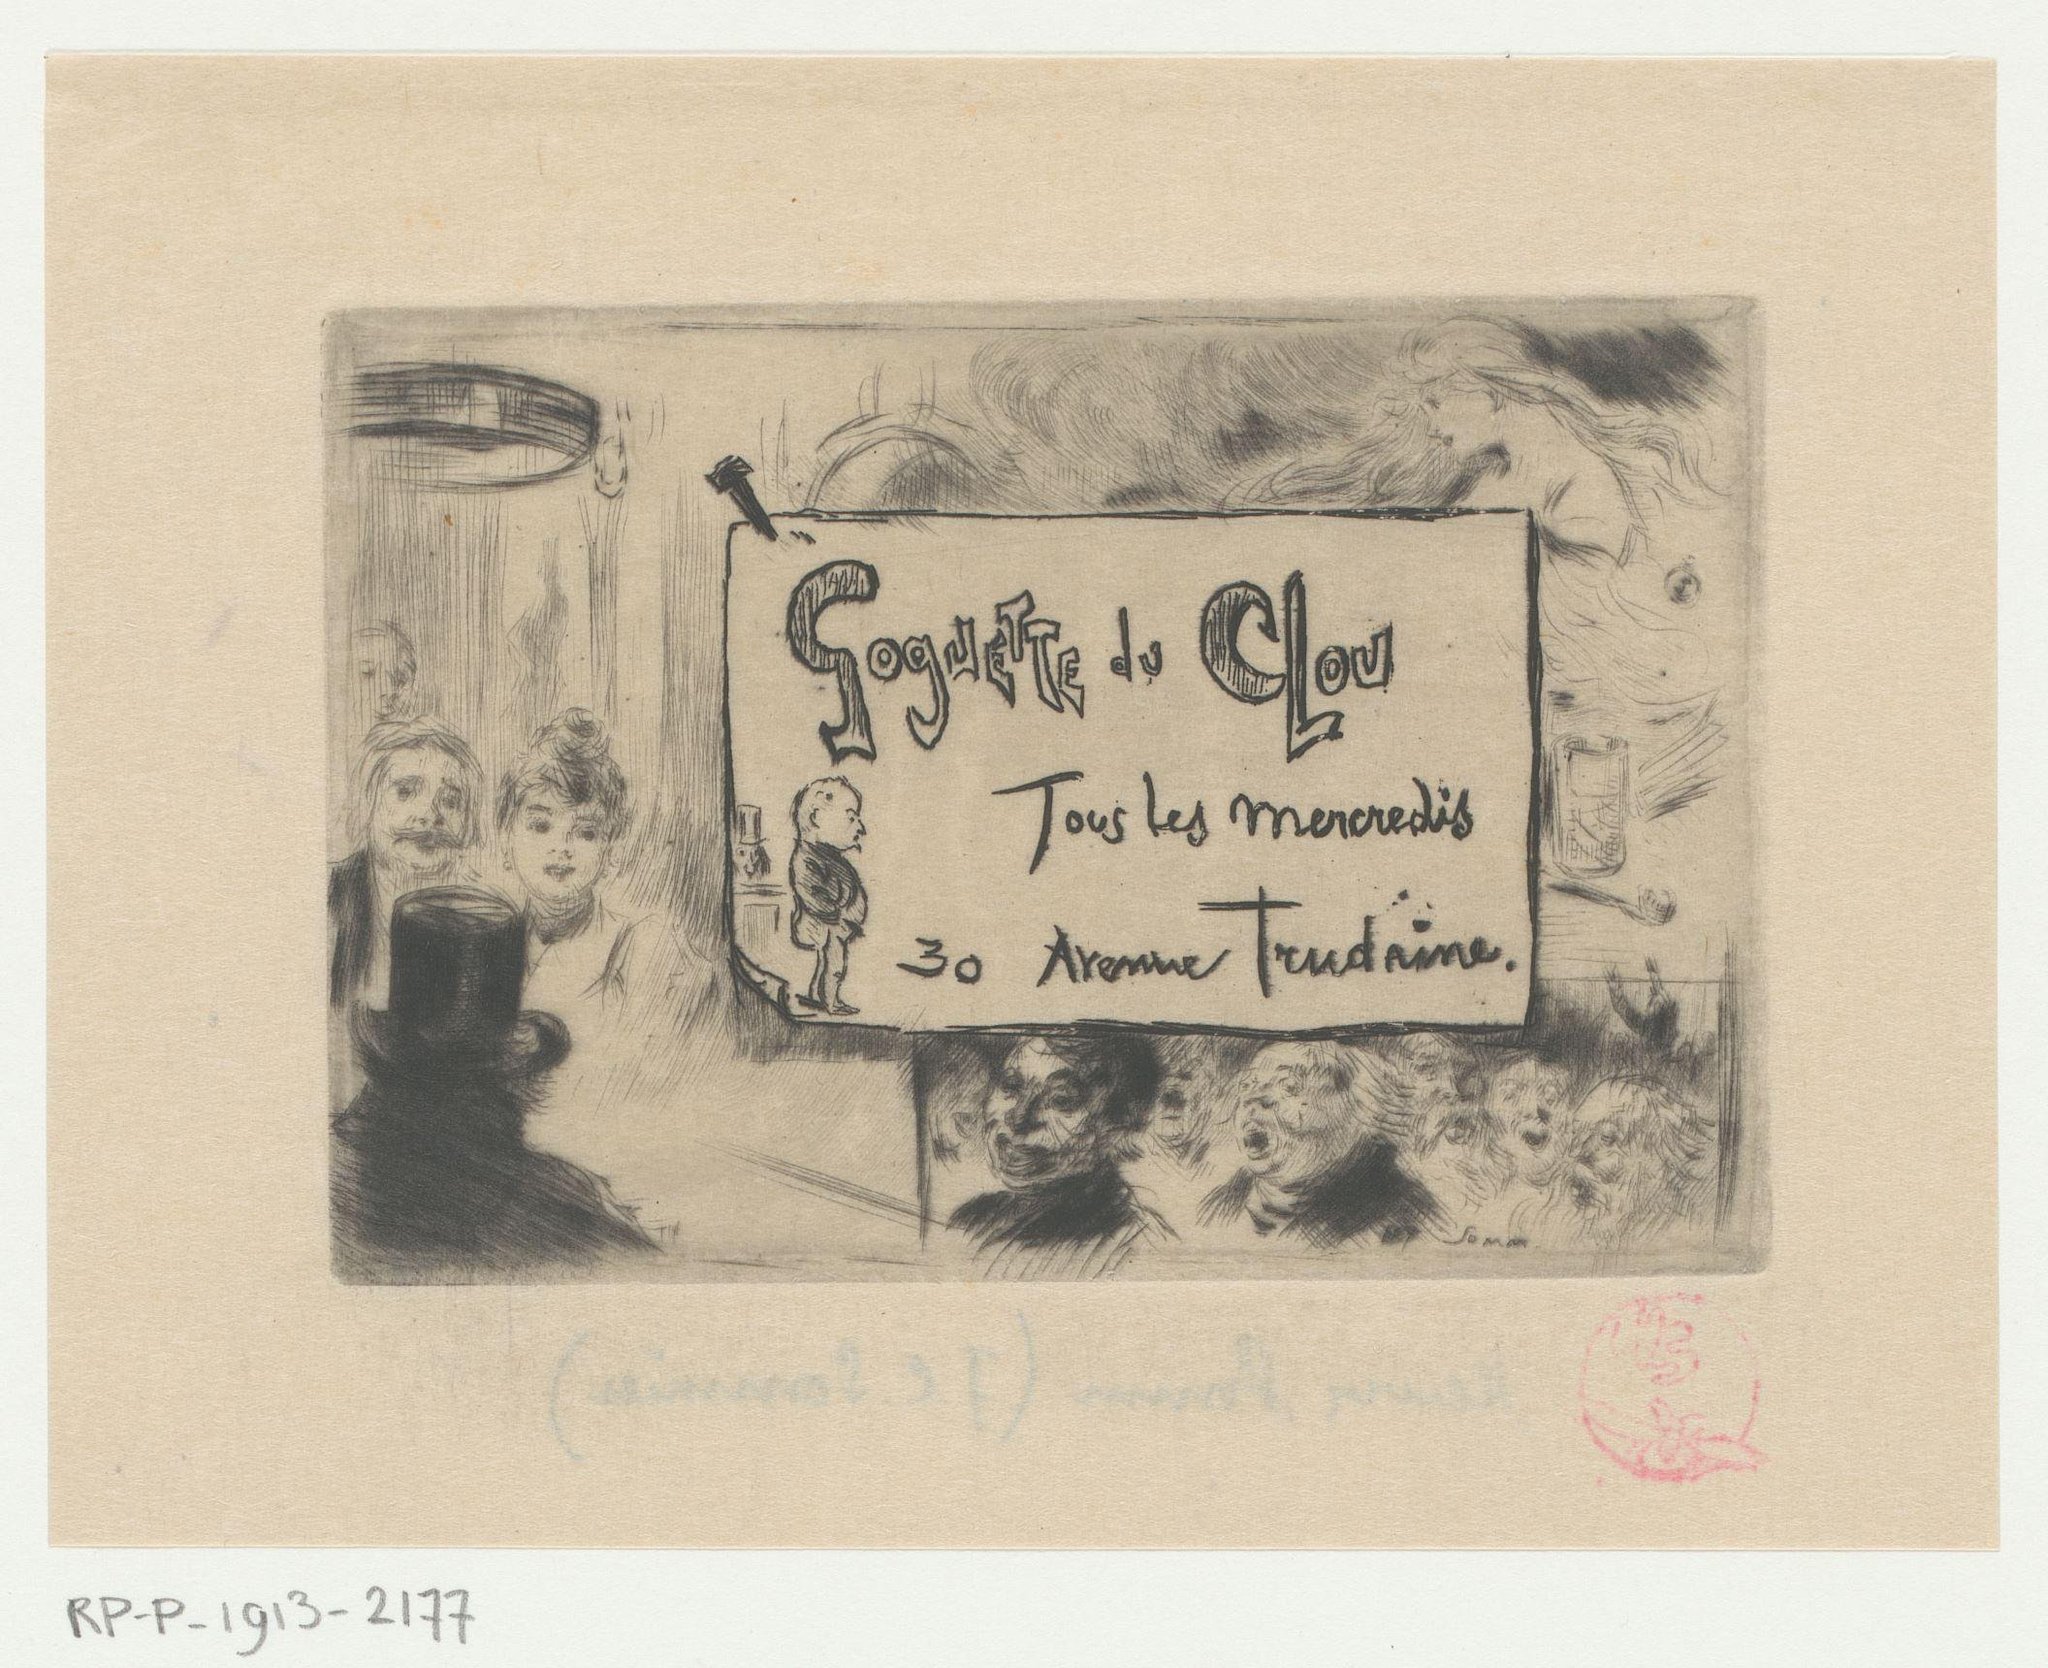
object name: print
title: Adreskaart van Goguette du Clou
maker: henry somm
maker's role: print maker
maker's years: 1844-1907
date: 1854-1907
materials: paper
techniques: drypoint, intaglio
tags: inn, coffee-house, public house, etc., vocal music, singing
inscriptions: collector's mark: Lugt 2233, collector's mark: Lugt 1370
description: Reclame- en adreskaart voor de zanggelegenheid Goguette du Clou, met diverse figuren in de marge.